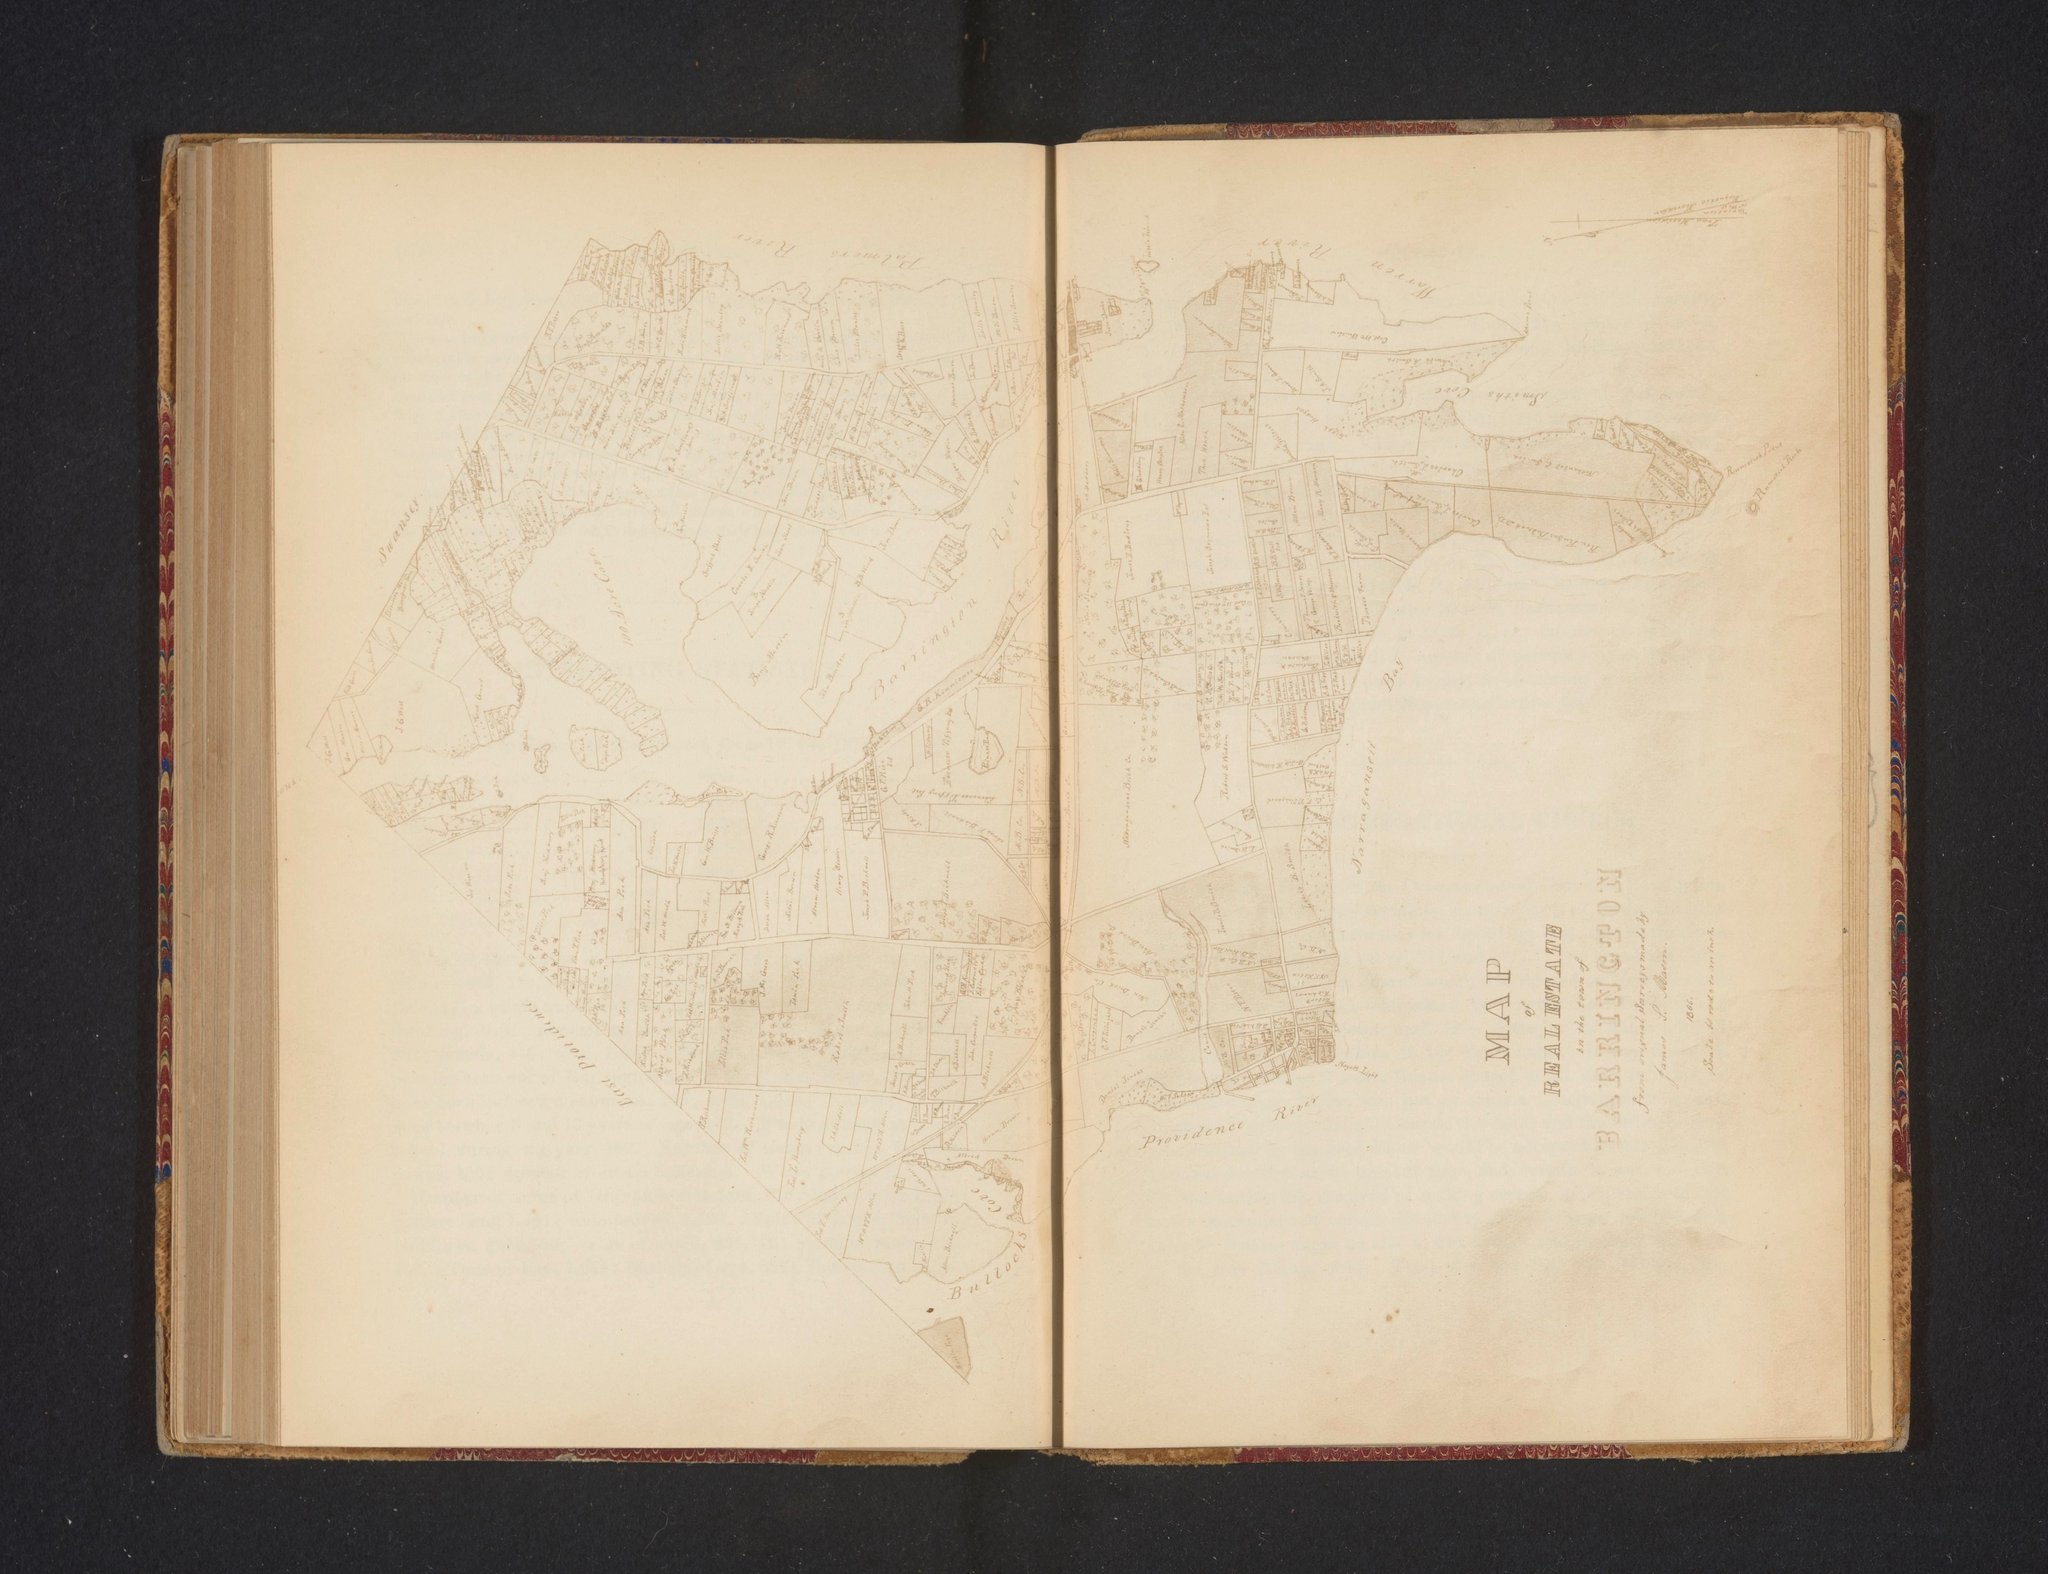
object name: page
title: Fotoreproductie van een plattegrond van Barrington door James J. Mason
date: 1865-1870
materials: photographic support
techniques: salted paper print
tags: maps of cities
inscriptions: inscription: ‘Map of real estate/ in the town of Barrington/ from original surveys by James L. Mason/ 1866/ Scale 60 yards to an inch’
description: Foto op de tweede en derde ongenummerde pagina's na pagina 178.